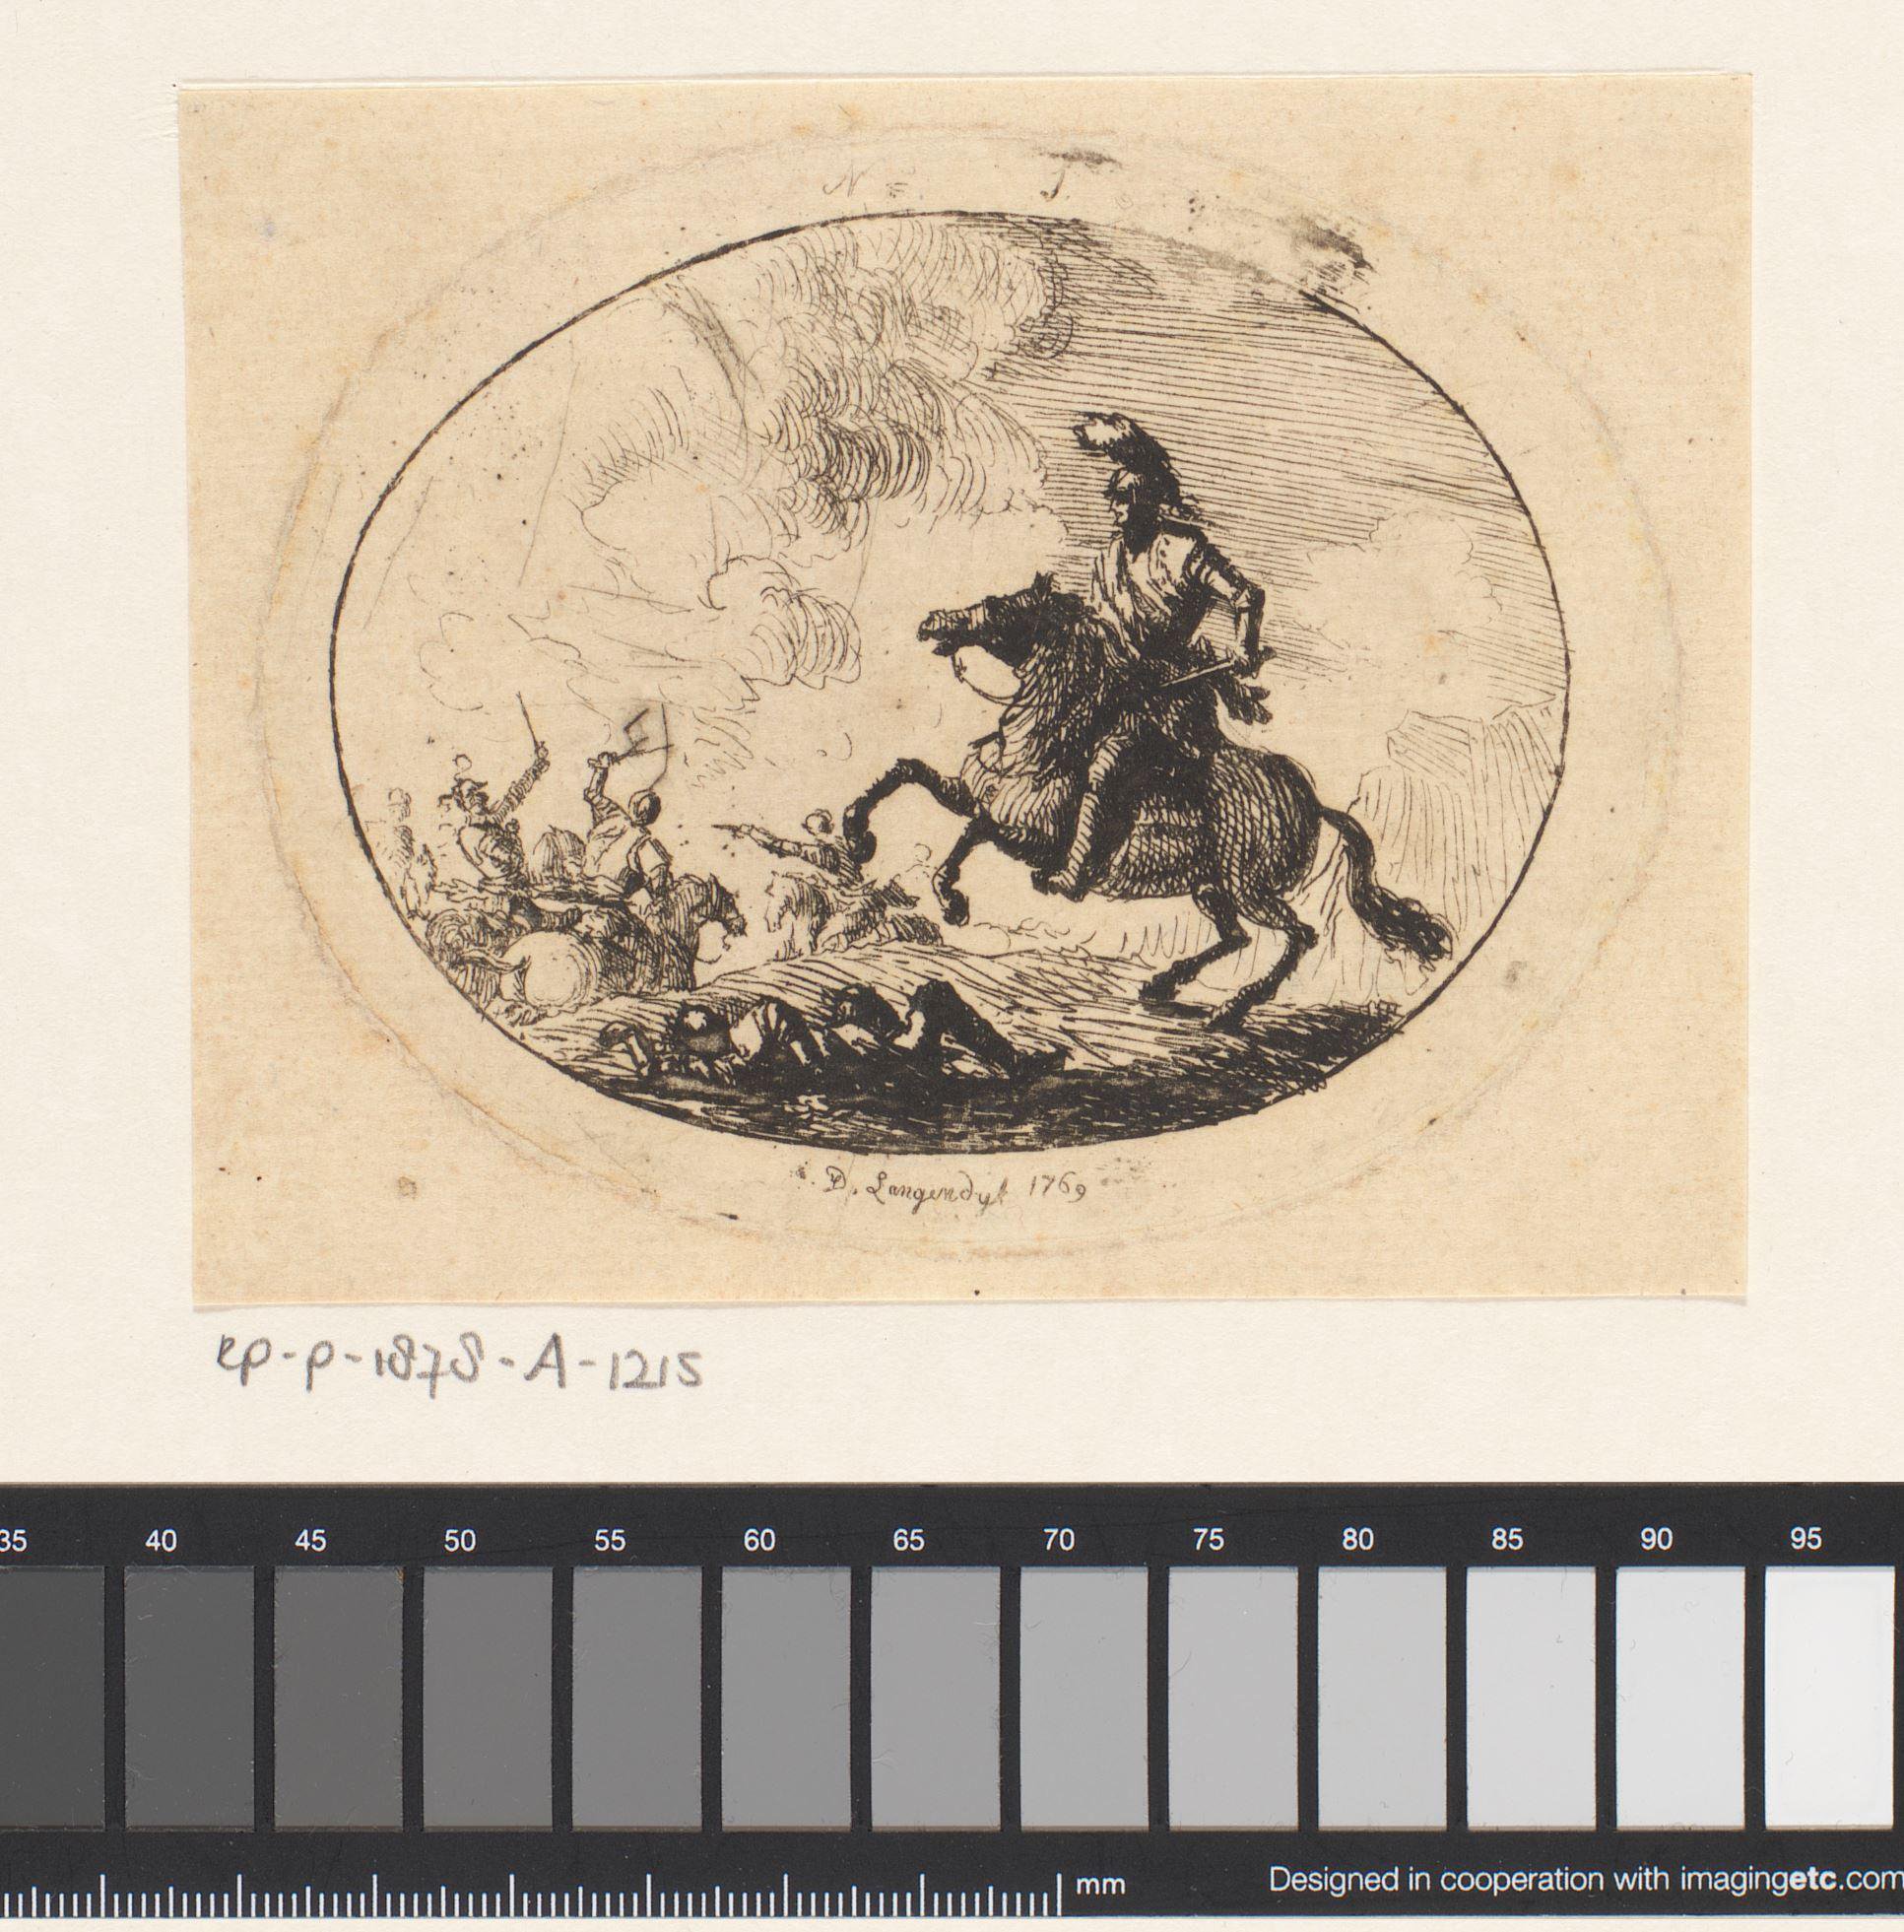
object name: print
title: Veldslag met ruiters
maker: dirk langendijk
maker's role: draughtsman, painter, print maker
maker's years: 1748-1805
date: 1769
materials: paper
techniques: etching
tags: riding a horse, ass, or mule; rider, horseman, battle, fighting in general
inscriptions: collector's mark: Lugt 2228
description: Een ruiter rijdt met een zwaard in de aanslag naar de linkerzijde. Voor hem ligt een gesneuvelde soldaat op de grond. Links op de achtergrond vechten vier ruiters. Ovale voorstelling, boven in de marge gemerkt: No 1.